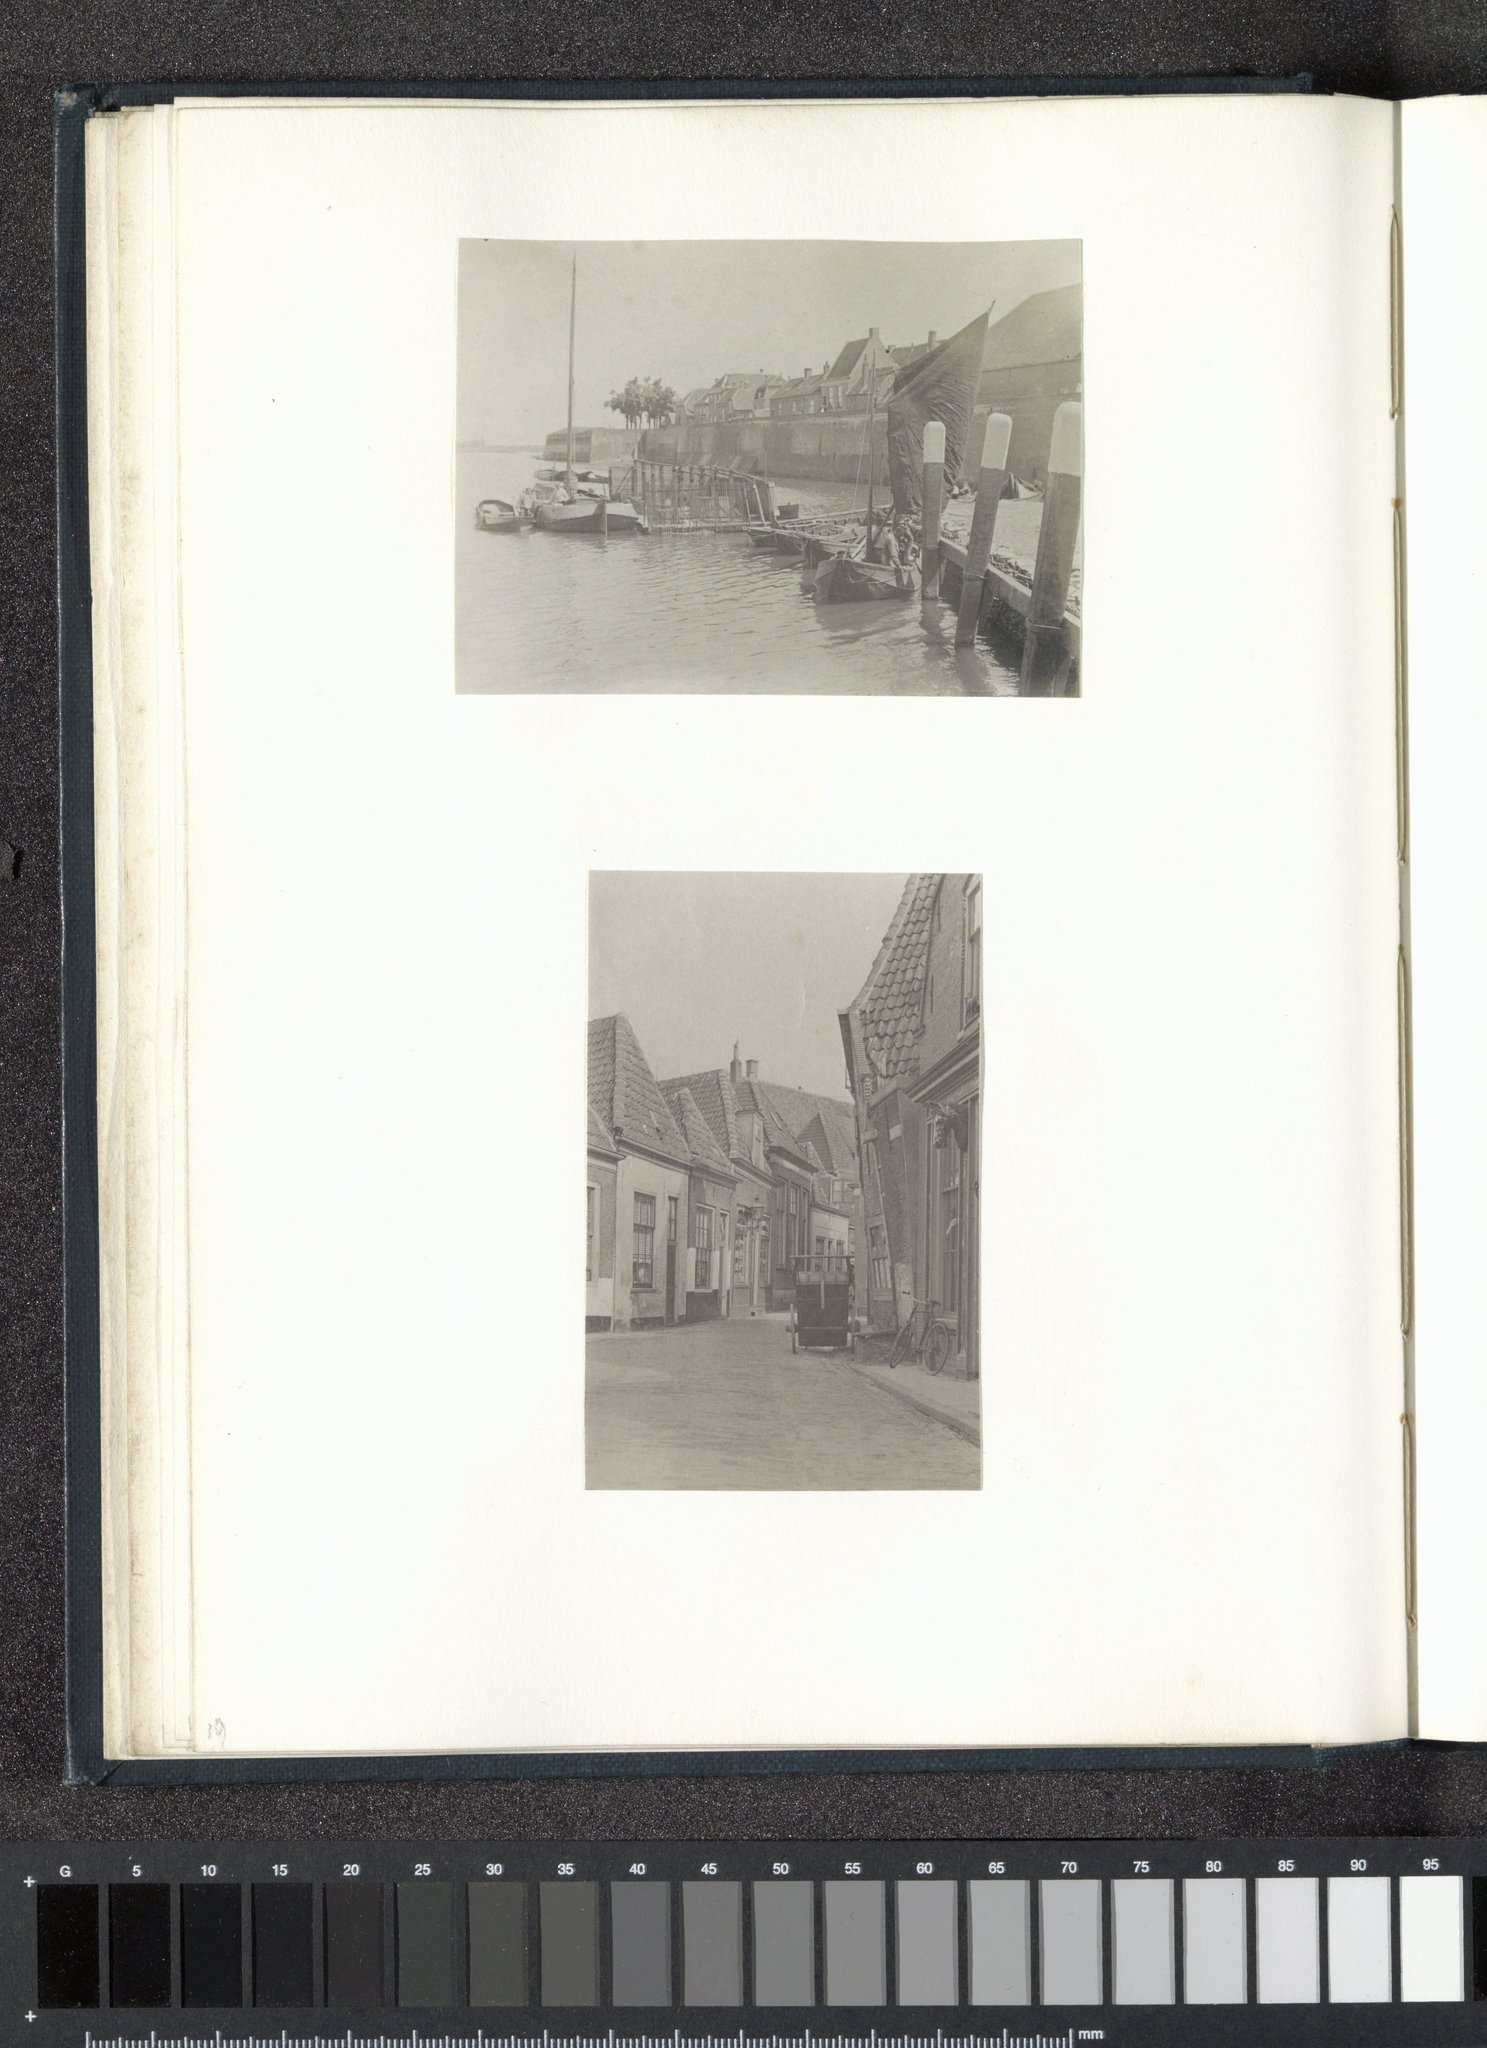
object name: photograph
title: Kade met schepen in Woudrichem, op de achtergrond de stadswal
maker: george hidderley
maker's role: fotograaf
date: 1900-1910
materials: paper, photographic support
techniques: gelatin silver print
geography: netherlands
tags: city-walls, quay (+ city(-scape) with figures, staffage), prospect of city, town panorama, silhouette of city, woudrichem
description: Onderdeel van fotoalbum met opnames van Volendam, Dordrecht, Gorinchem en Woudrichem.